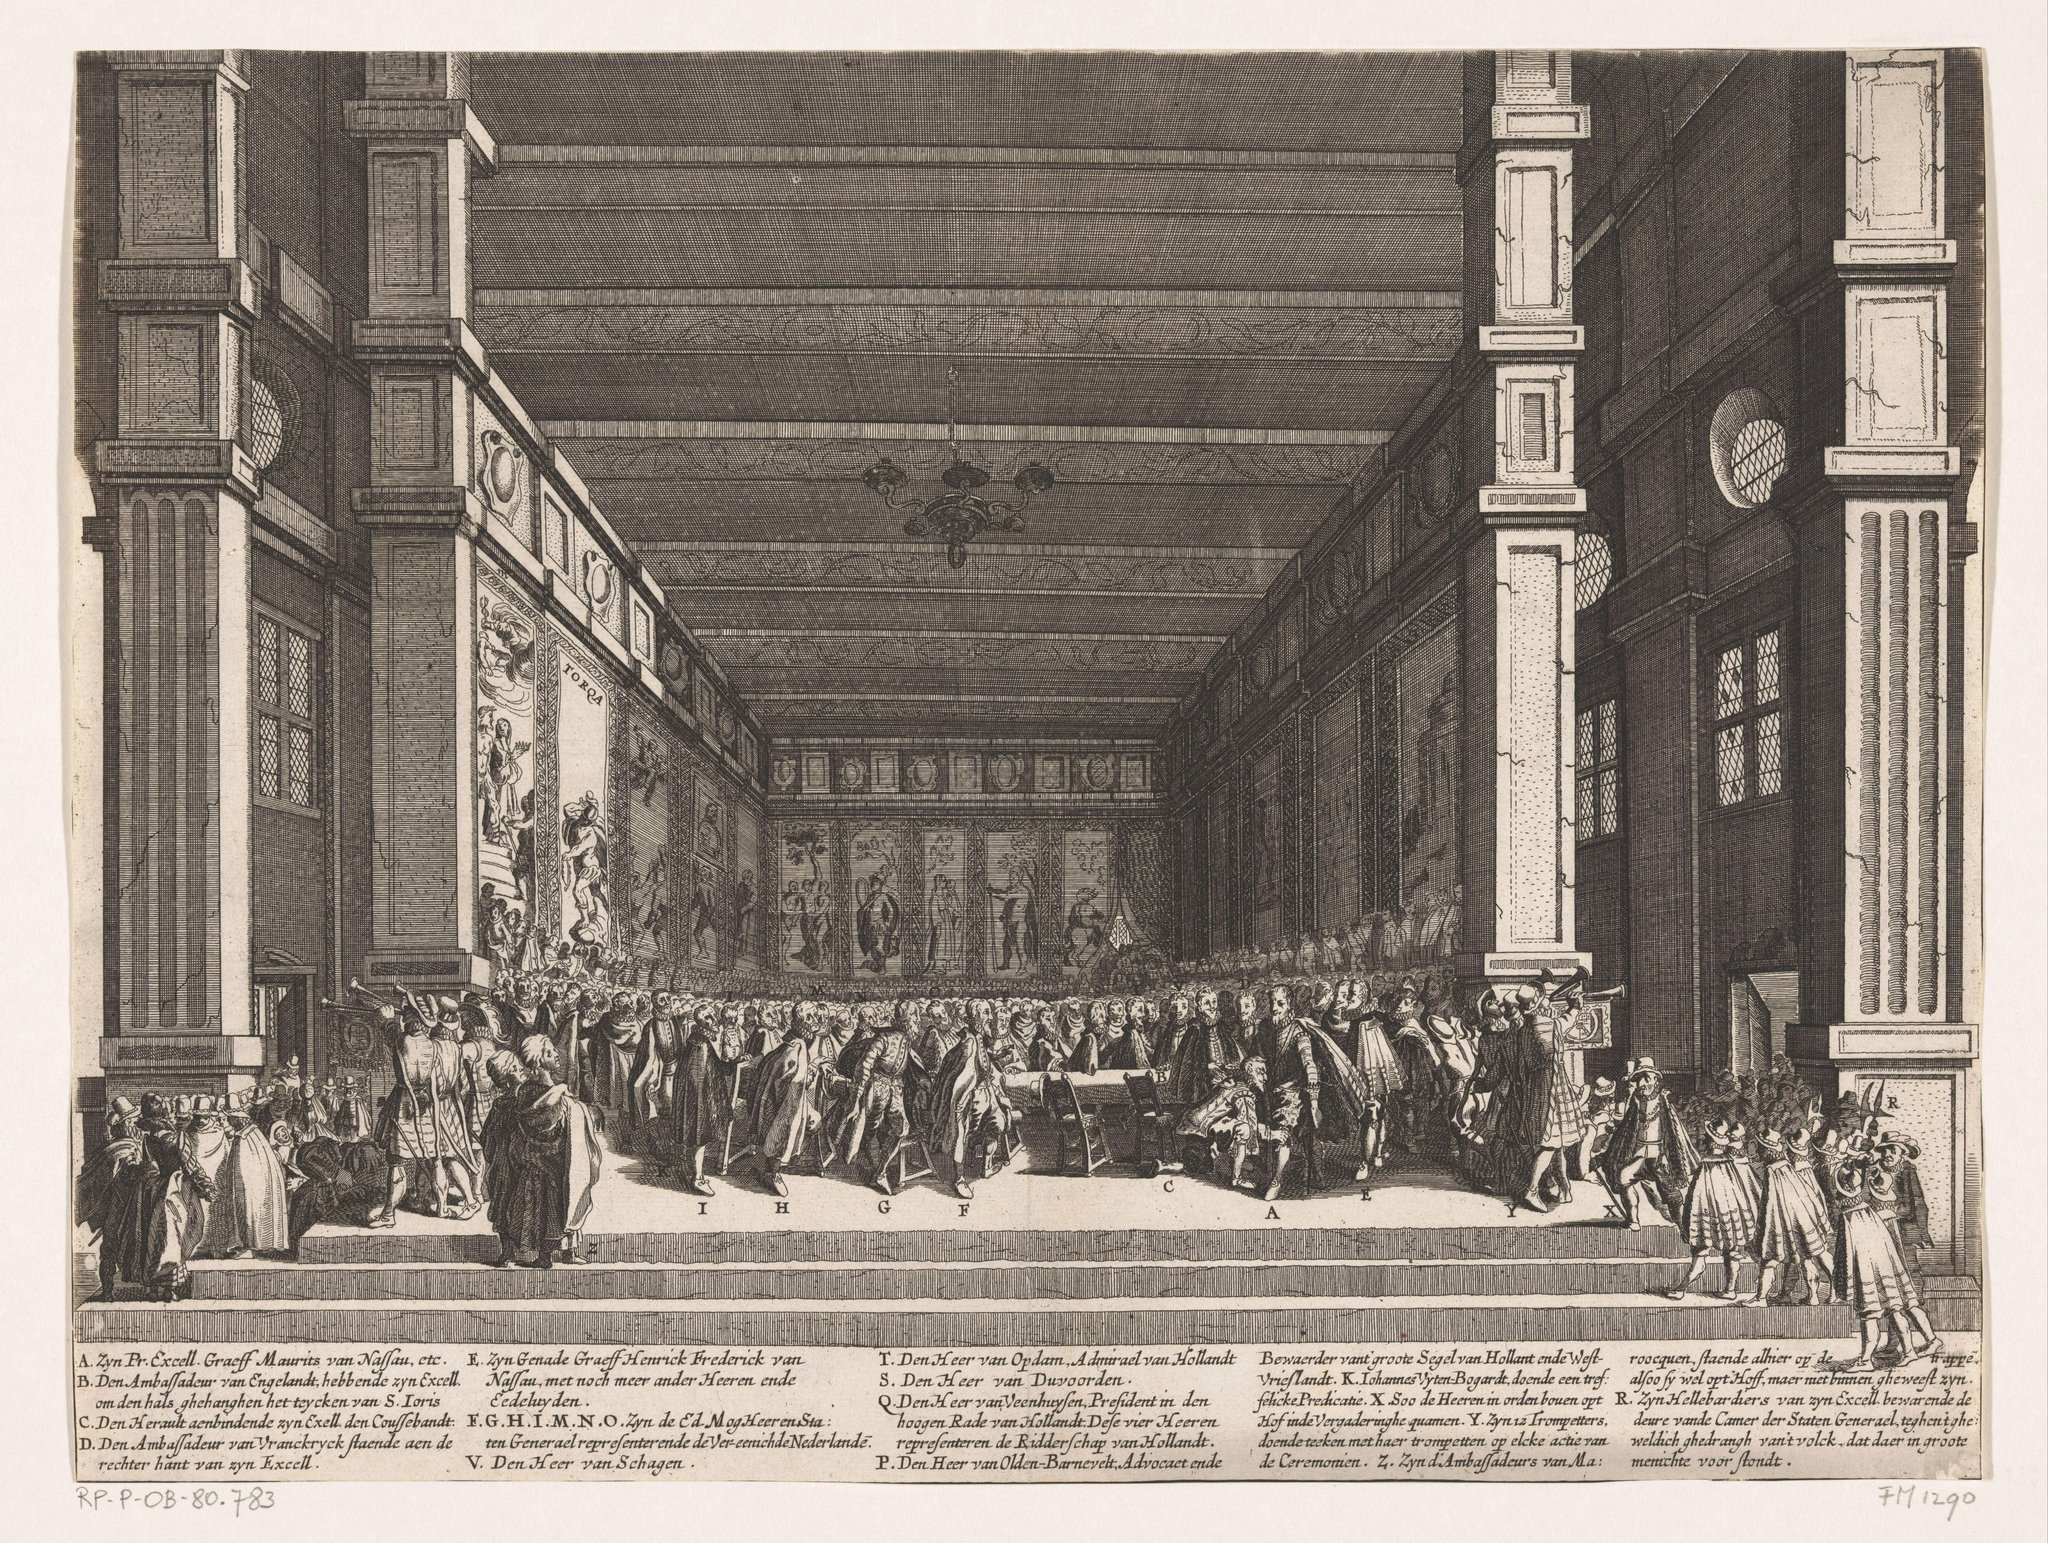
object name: print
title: De investituur van Maurits met de Orde van de Kousenband, 1613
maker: Anonymous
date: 1613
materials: paper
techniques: etching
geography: northern netherlands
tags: maurice (prince of orange), clothing (~ knighting ceremony), knighthood order (garter)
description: De investituur van Maurits met de Orde van de Kousenband, 4 februari 1613. Maurits krijgt in de grote zaal van het Binnenhof te 's-Gravenhage door een heraut de kousenband omgedaan in aanwezigheid van de Engelse ambassadeur, Johan van Oldenbarnevelt, de leden van de Staten-Generaal en vele andere gasten. In het onderschrift de legenda A-R in het Nederlands.